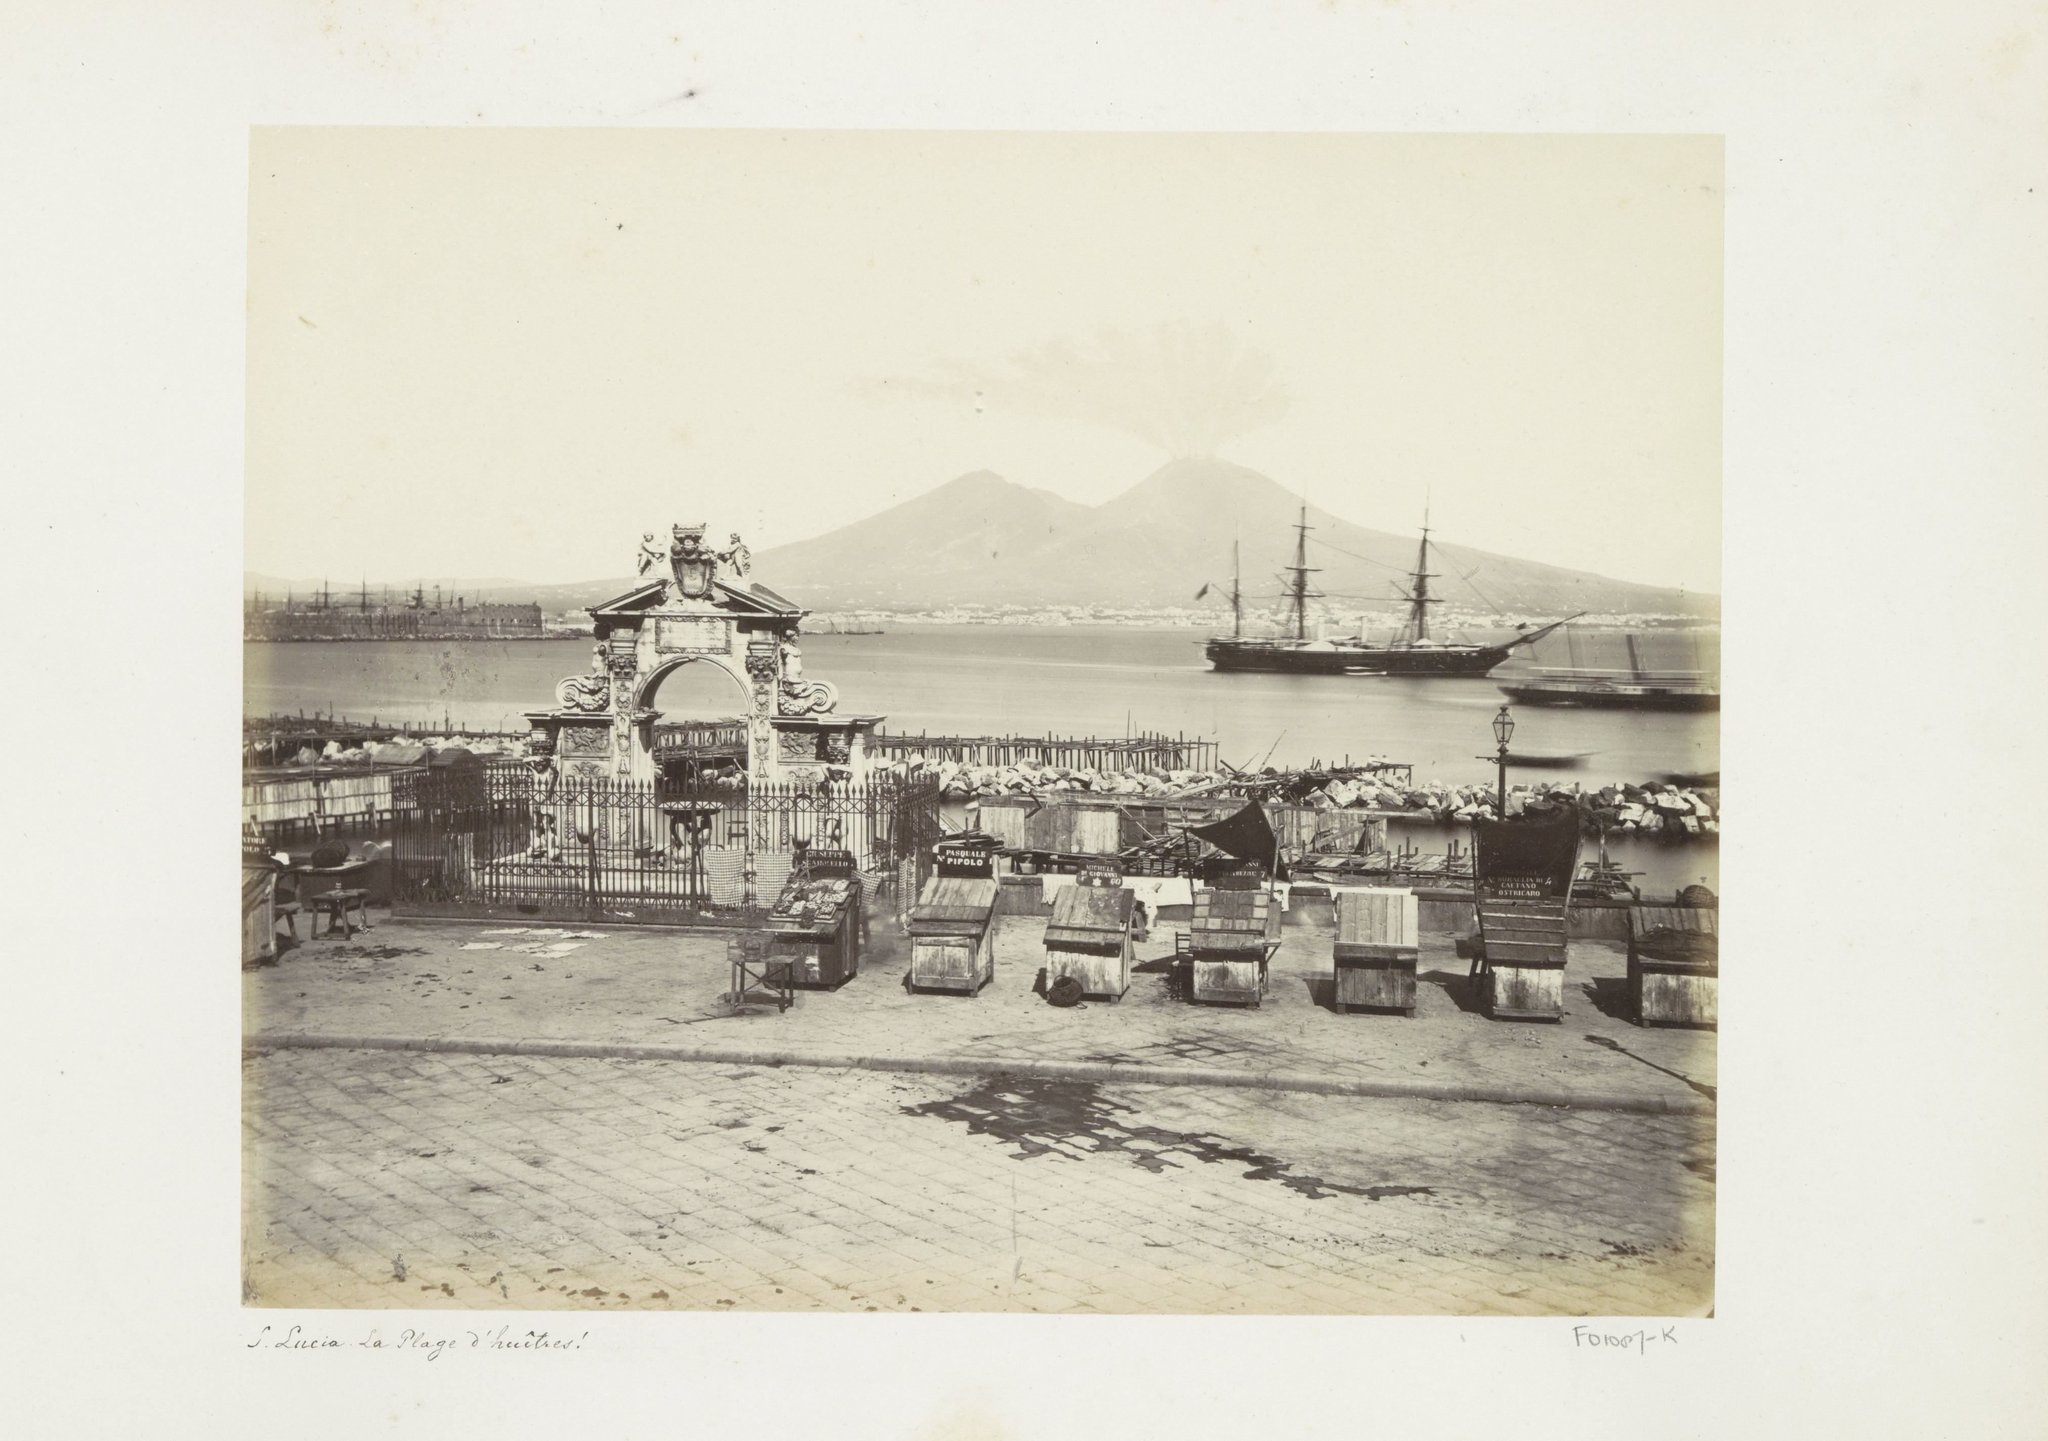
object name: photograph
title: Haven van Napels in de Santa Luciabuurt met op de voorgrond stallen van oesterverkopers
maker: giorgio sommer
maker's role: fotograaf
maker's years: 1834-1914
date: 1865-1875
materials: paper, photographic support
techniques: albumen print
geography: naples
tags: harbour (+ view ~ vehicle, ship, etc.), stall, booth (~ market), naples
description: Onderdeel van Reisalbum met foto's van bezienswaardigheden in Napels en omgeving.